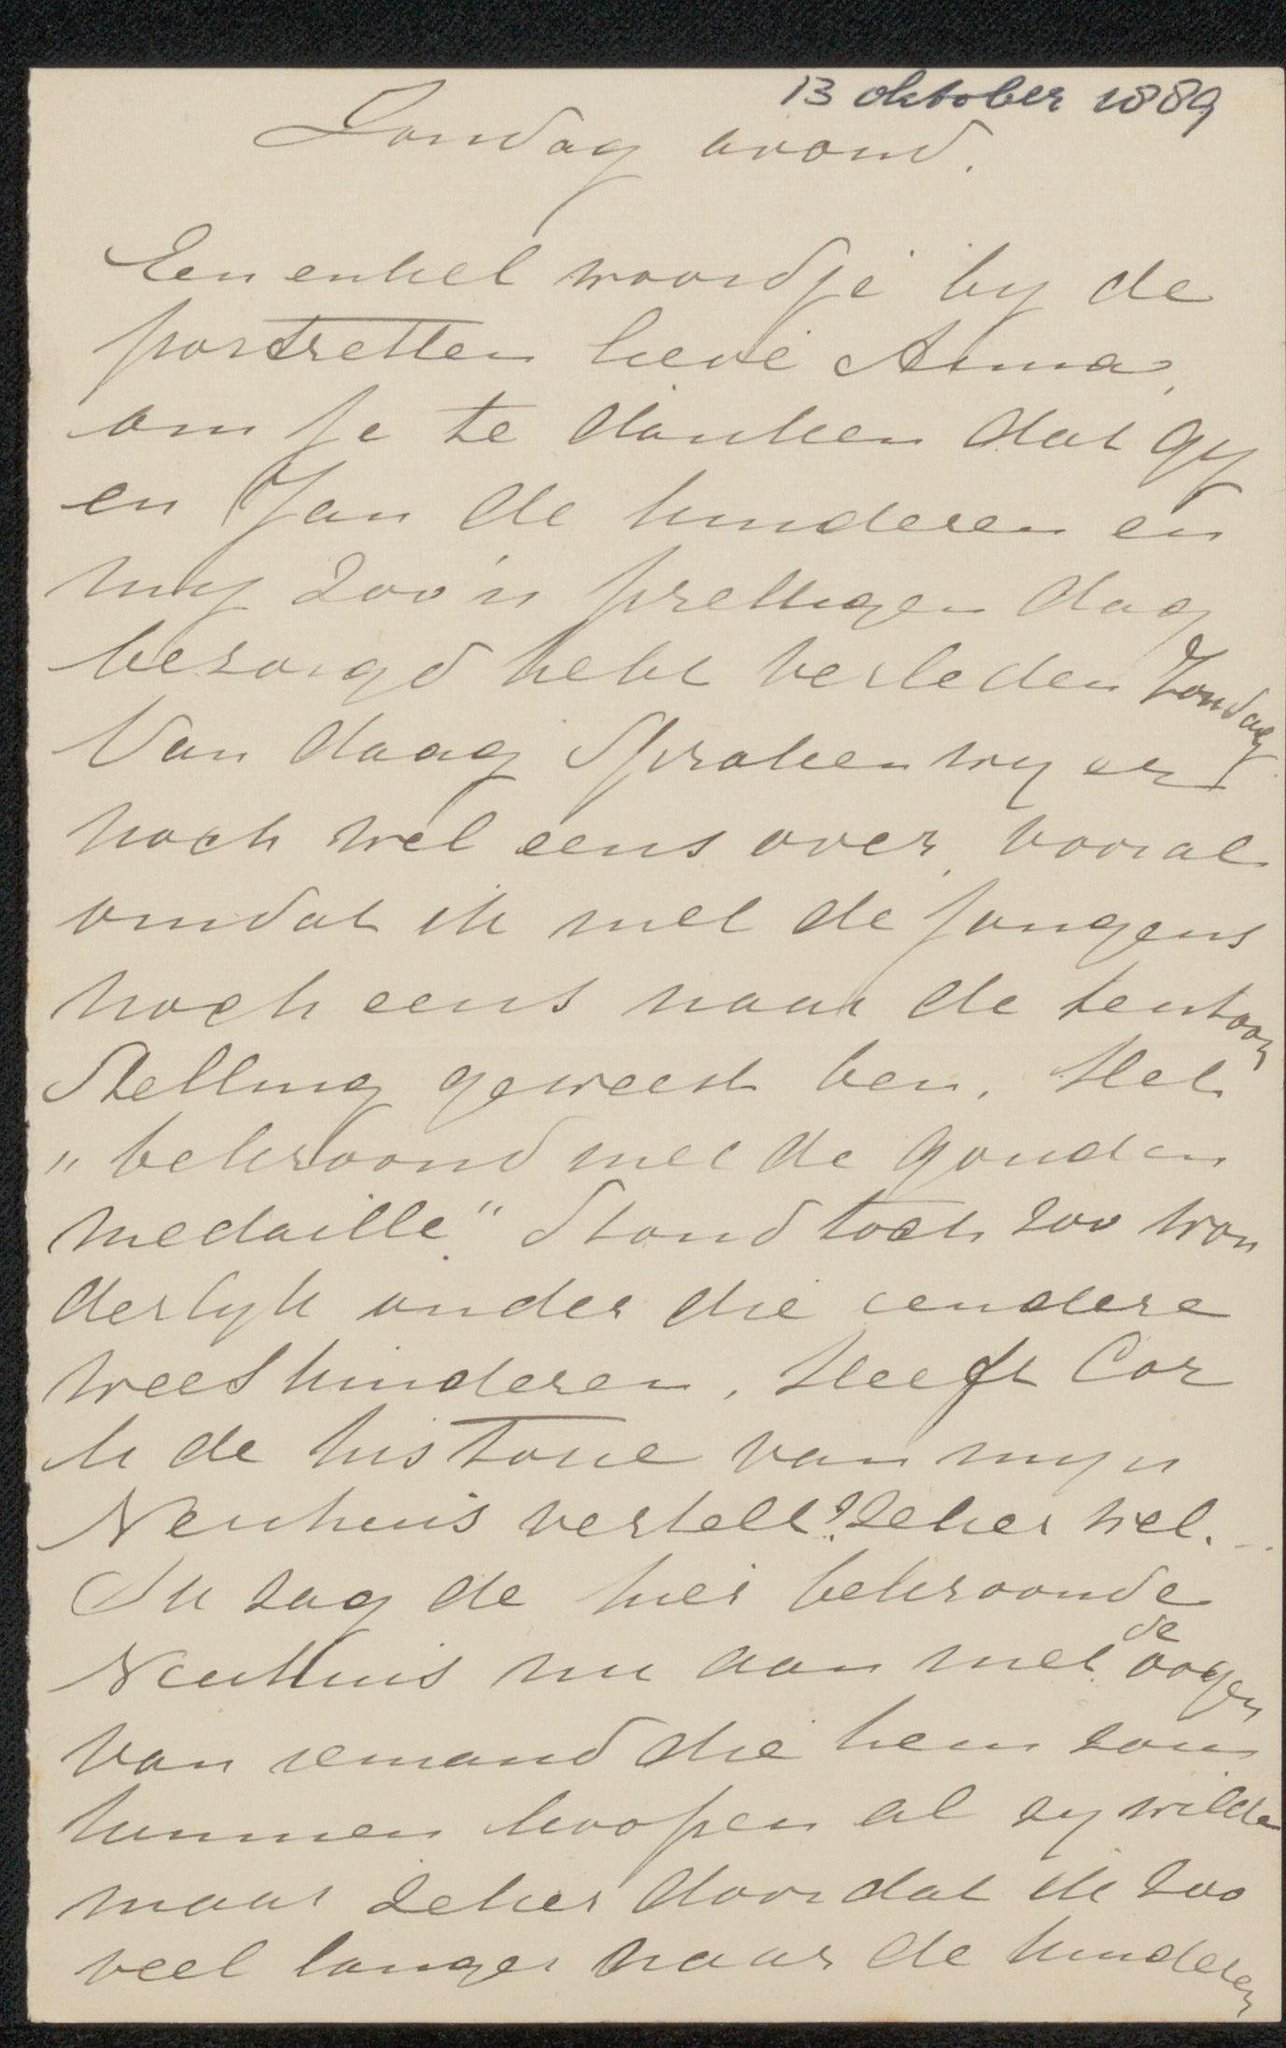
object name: letter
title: Brief aan Anna Dorothea Dirks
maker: jacoba cornelia jolles-singels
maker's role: schrijver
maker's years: 1847-1901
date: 1889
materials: ink, paper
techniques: pen, writing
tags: dordrecht, painter, print maker, draughtsman, designer, jan veth, utrecht, albert neuhuys (1844-1914), artist, anna dorothea dirks, leiden, amsterdam, william makepeace thackeray, exhibition ~ art, historical persons (portraits and scenes from the life)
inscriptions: collector's mark: ‘RPK’